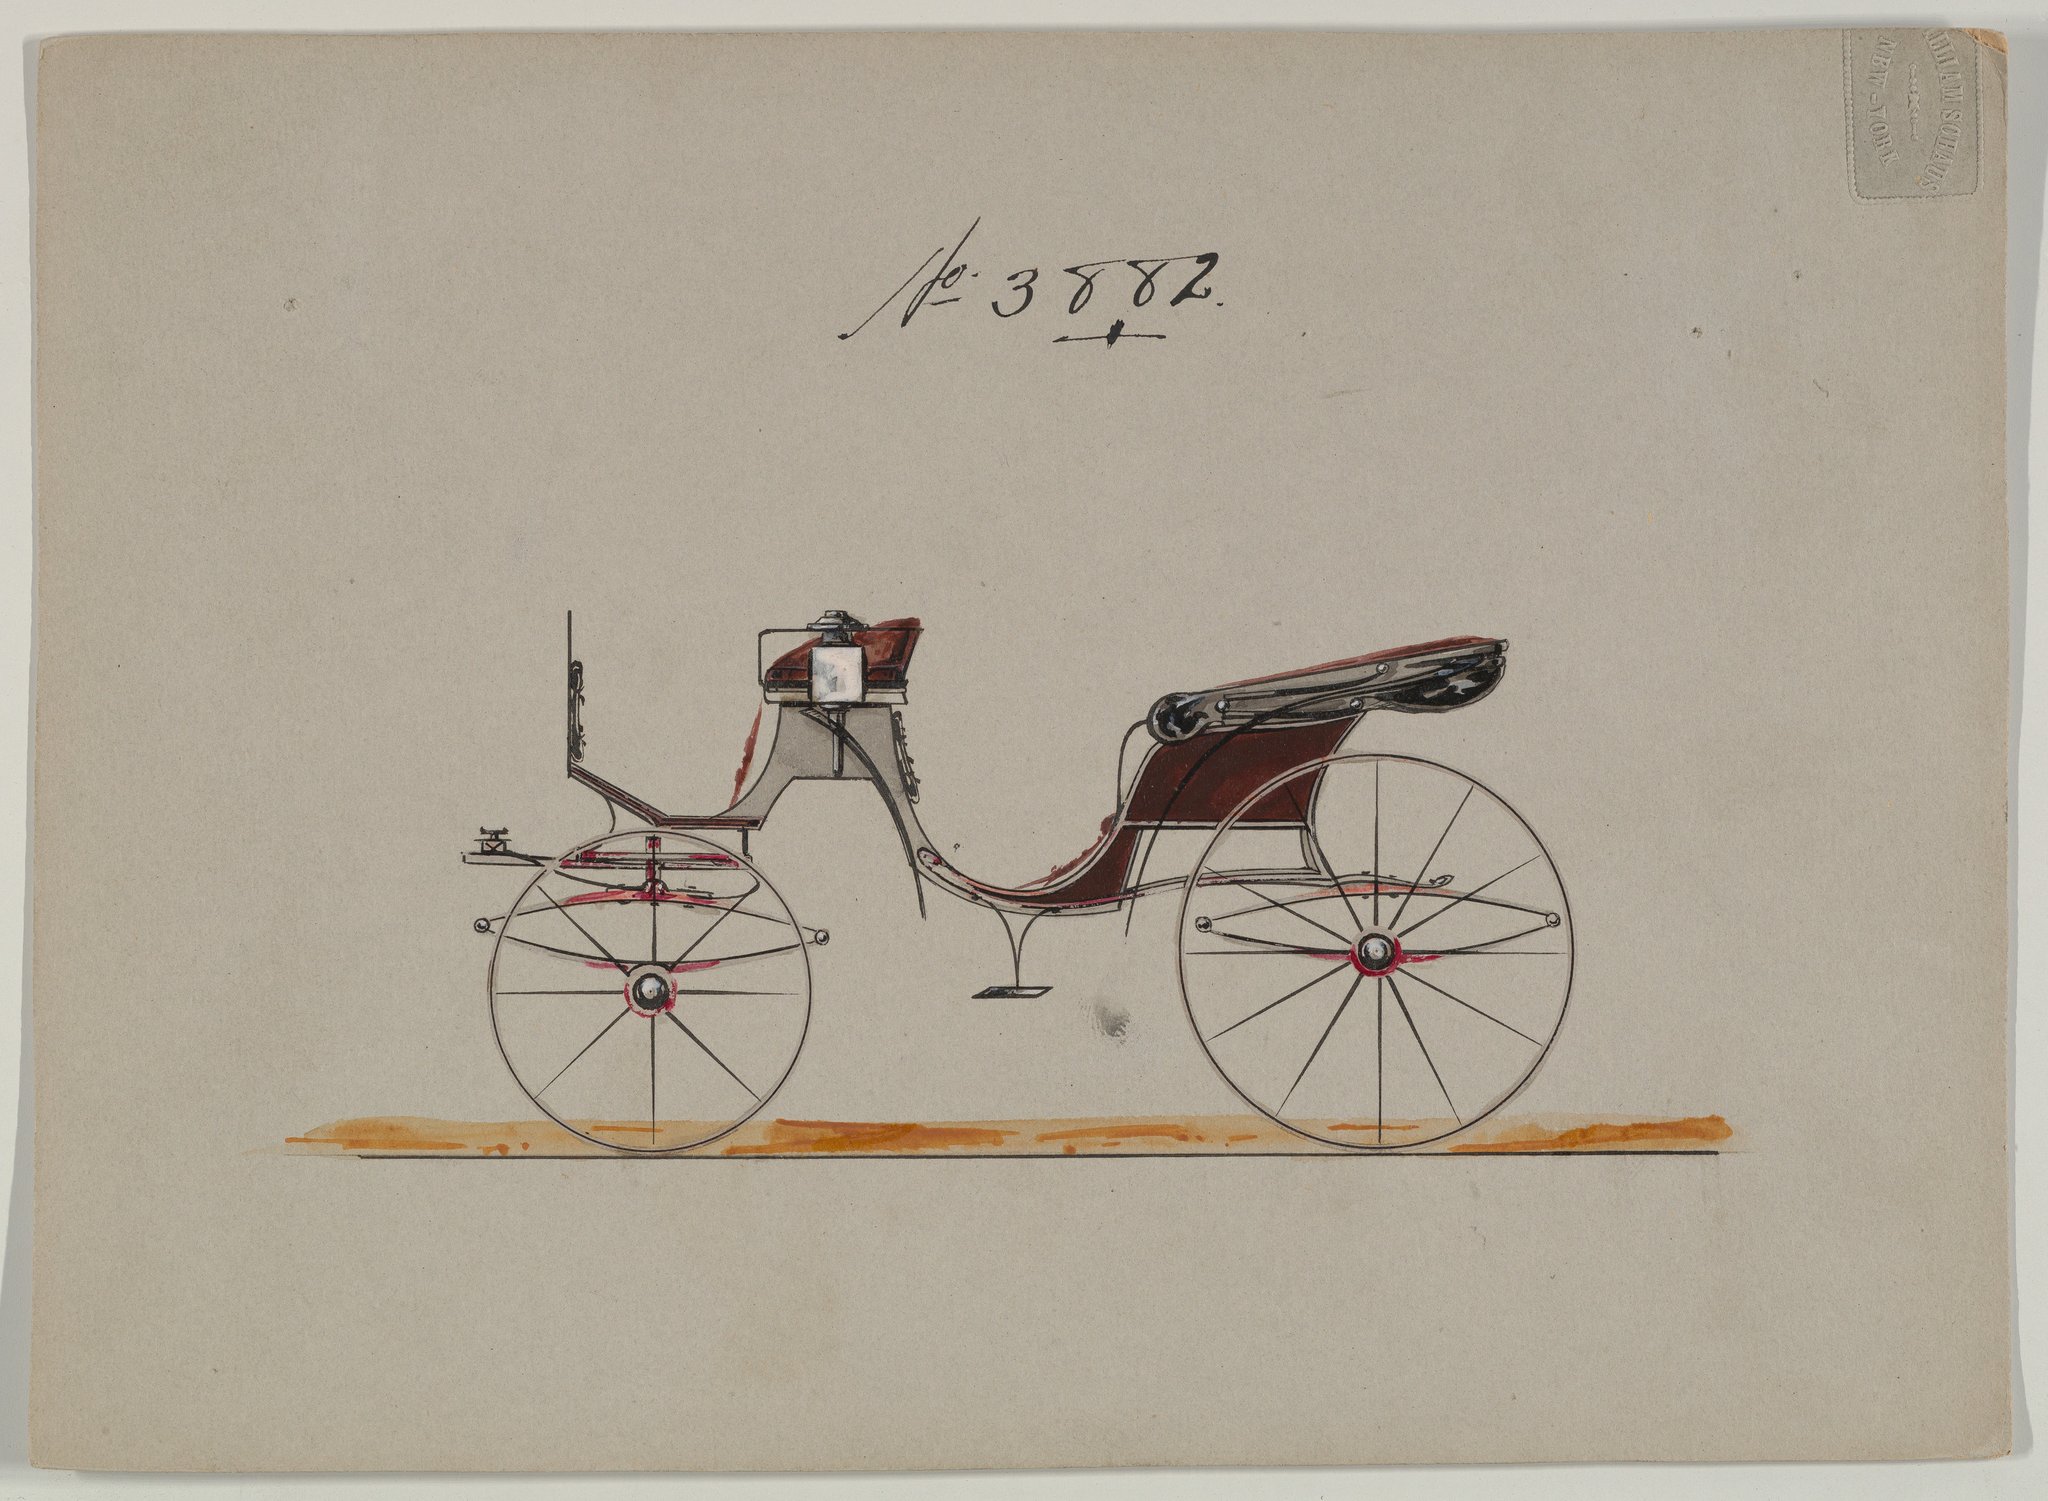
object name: drawing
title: Design for Cabriolet or Victoria, no. 3882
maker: brewster & co.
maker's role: manufacturer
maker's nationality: american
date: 1884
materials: gouache, ink, watercolor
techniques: pen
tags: carriages